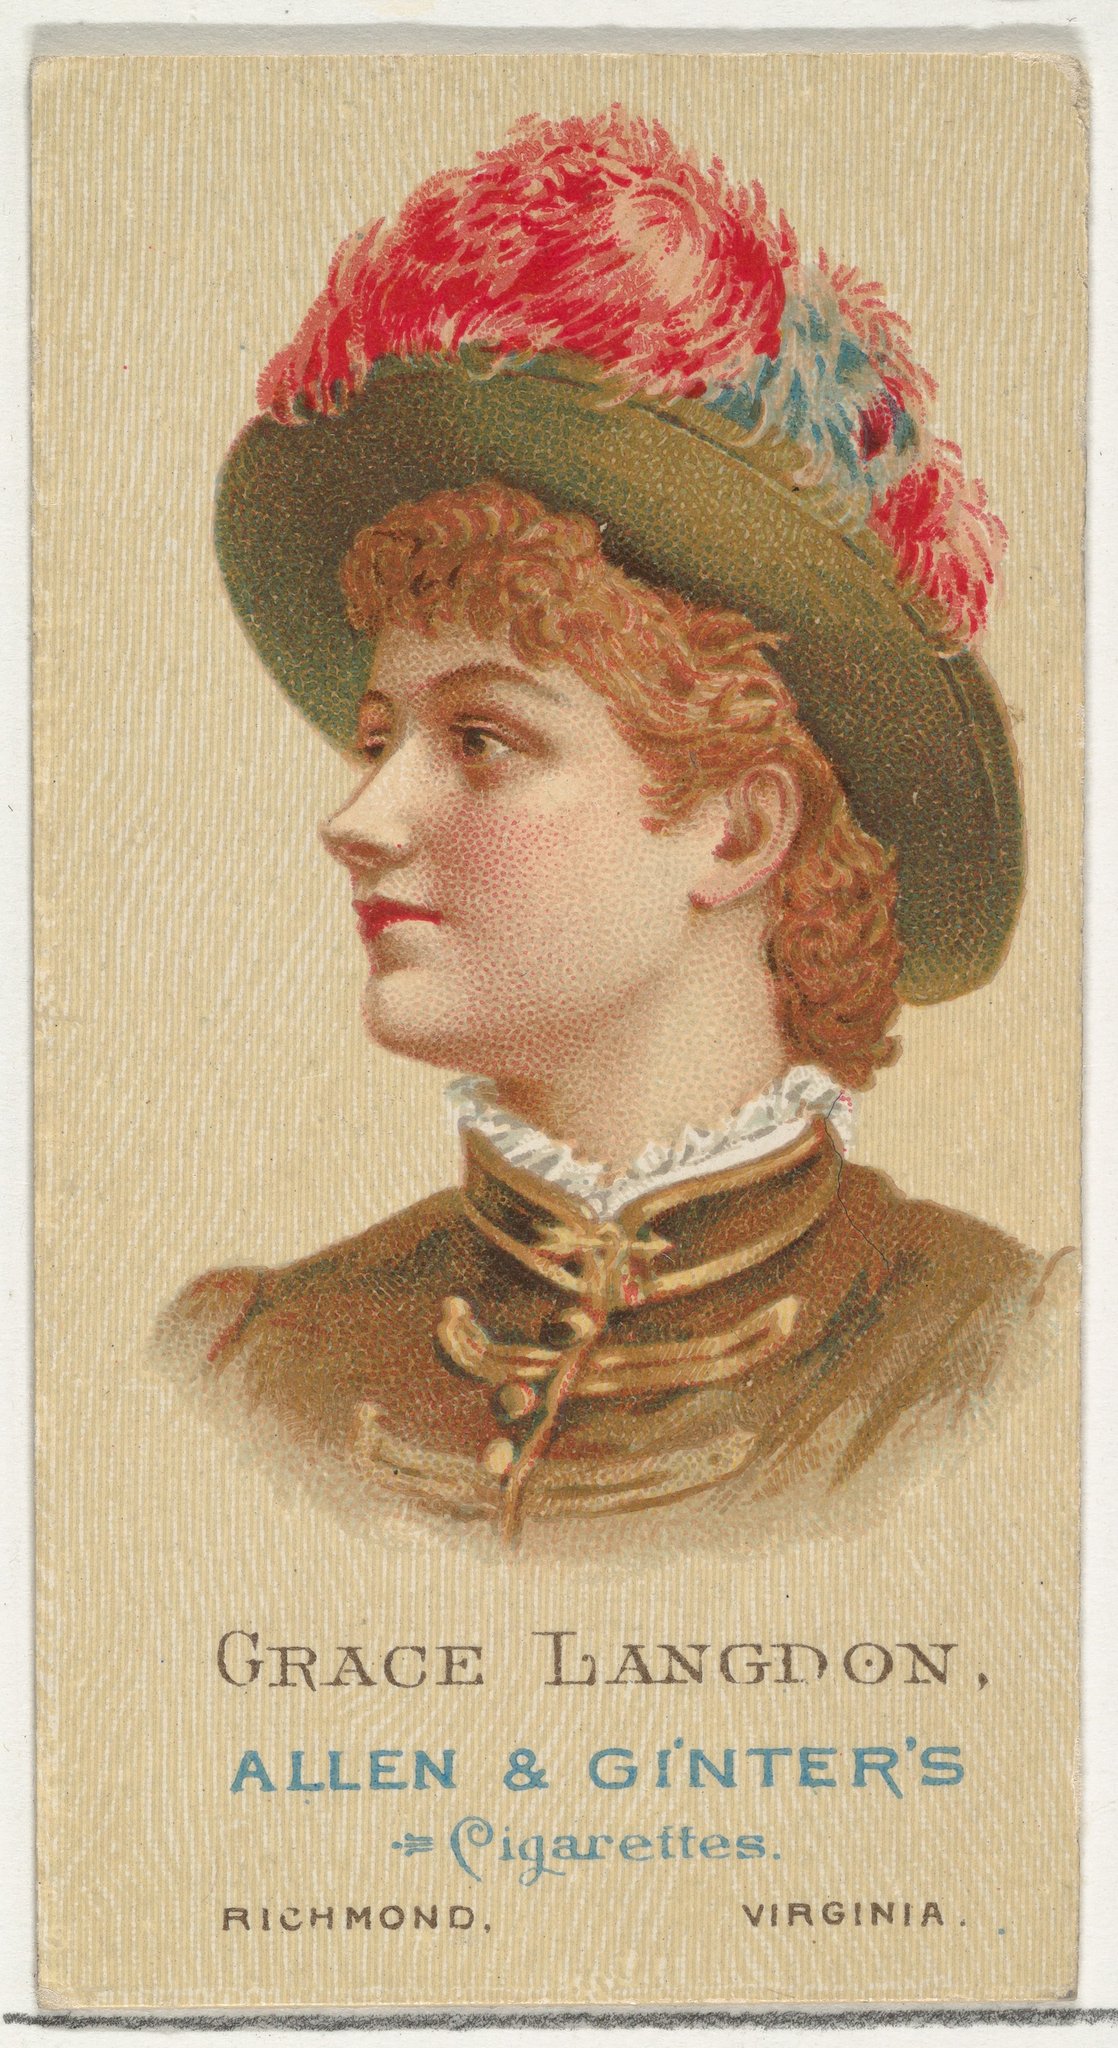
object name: print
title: Grace Langdon, from World's Beauties, Series 2 (N27) for Allen & Ginter Cigarettes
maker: allen & ginter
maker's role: publisher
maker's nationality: american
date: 1888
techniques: color lithograph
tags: women